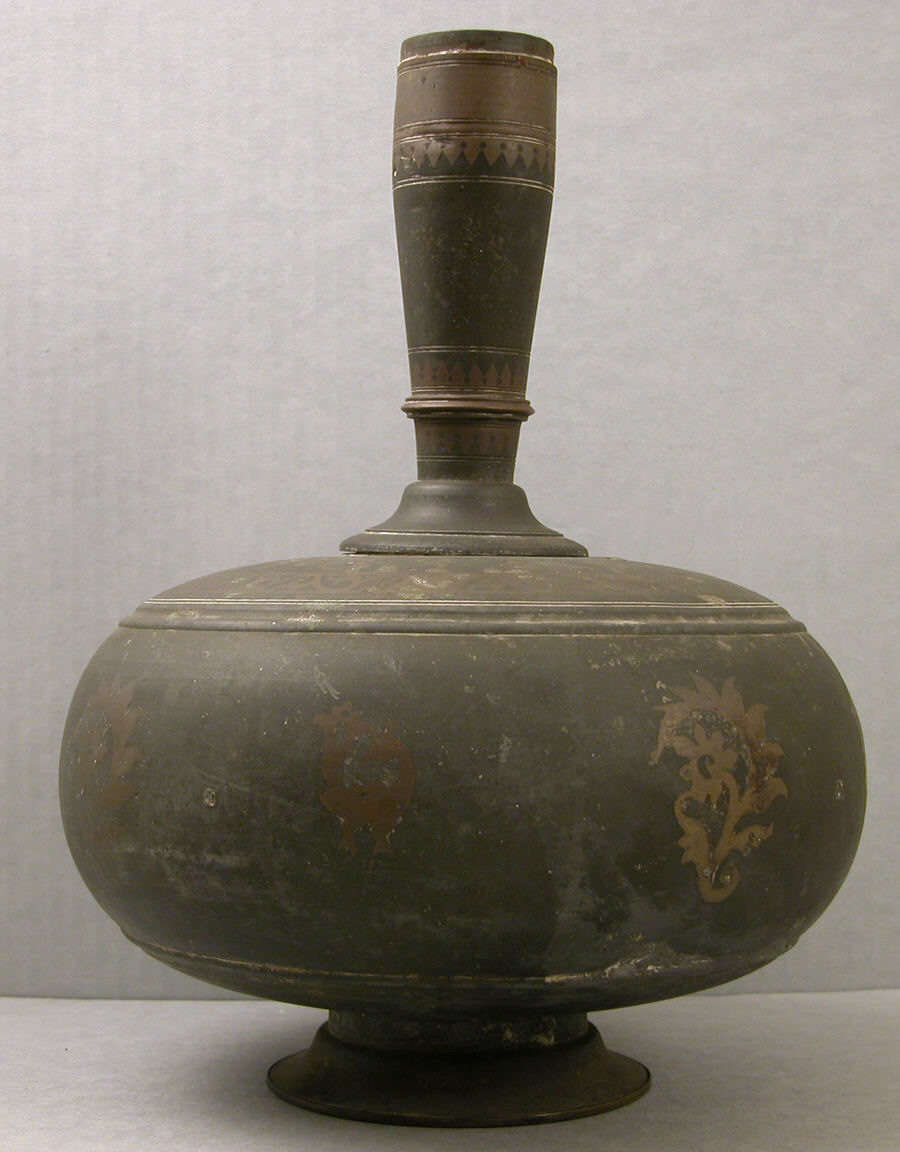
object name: bottle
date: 1701-1900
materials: brass, metal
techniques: inlay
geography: india